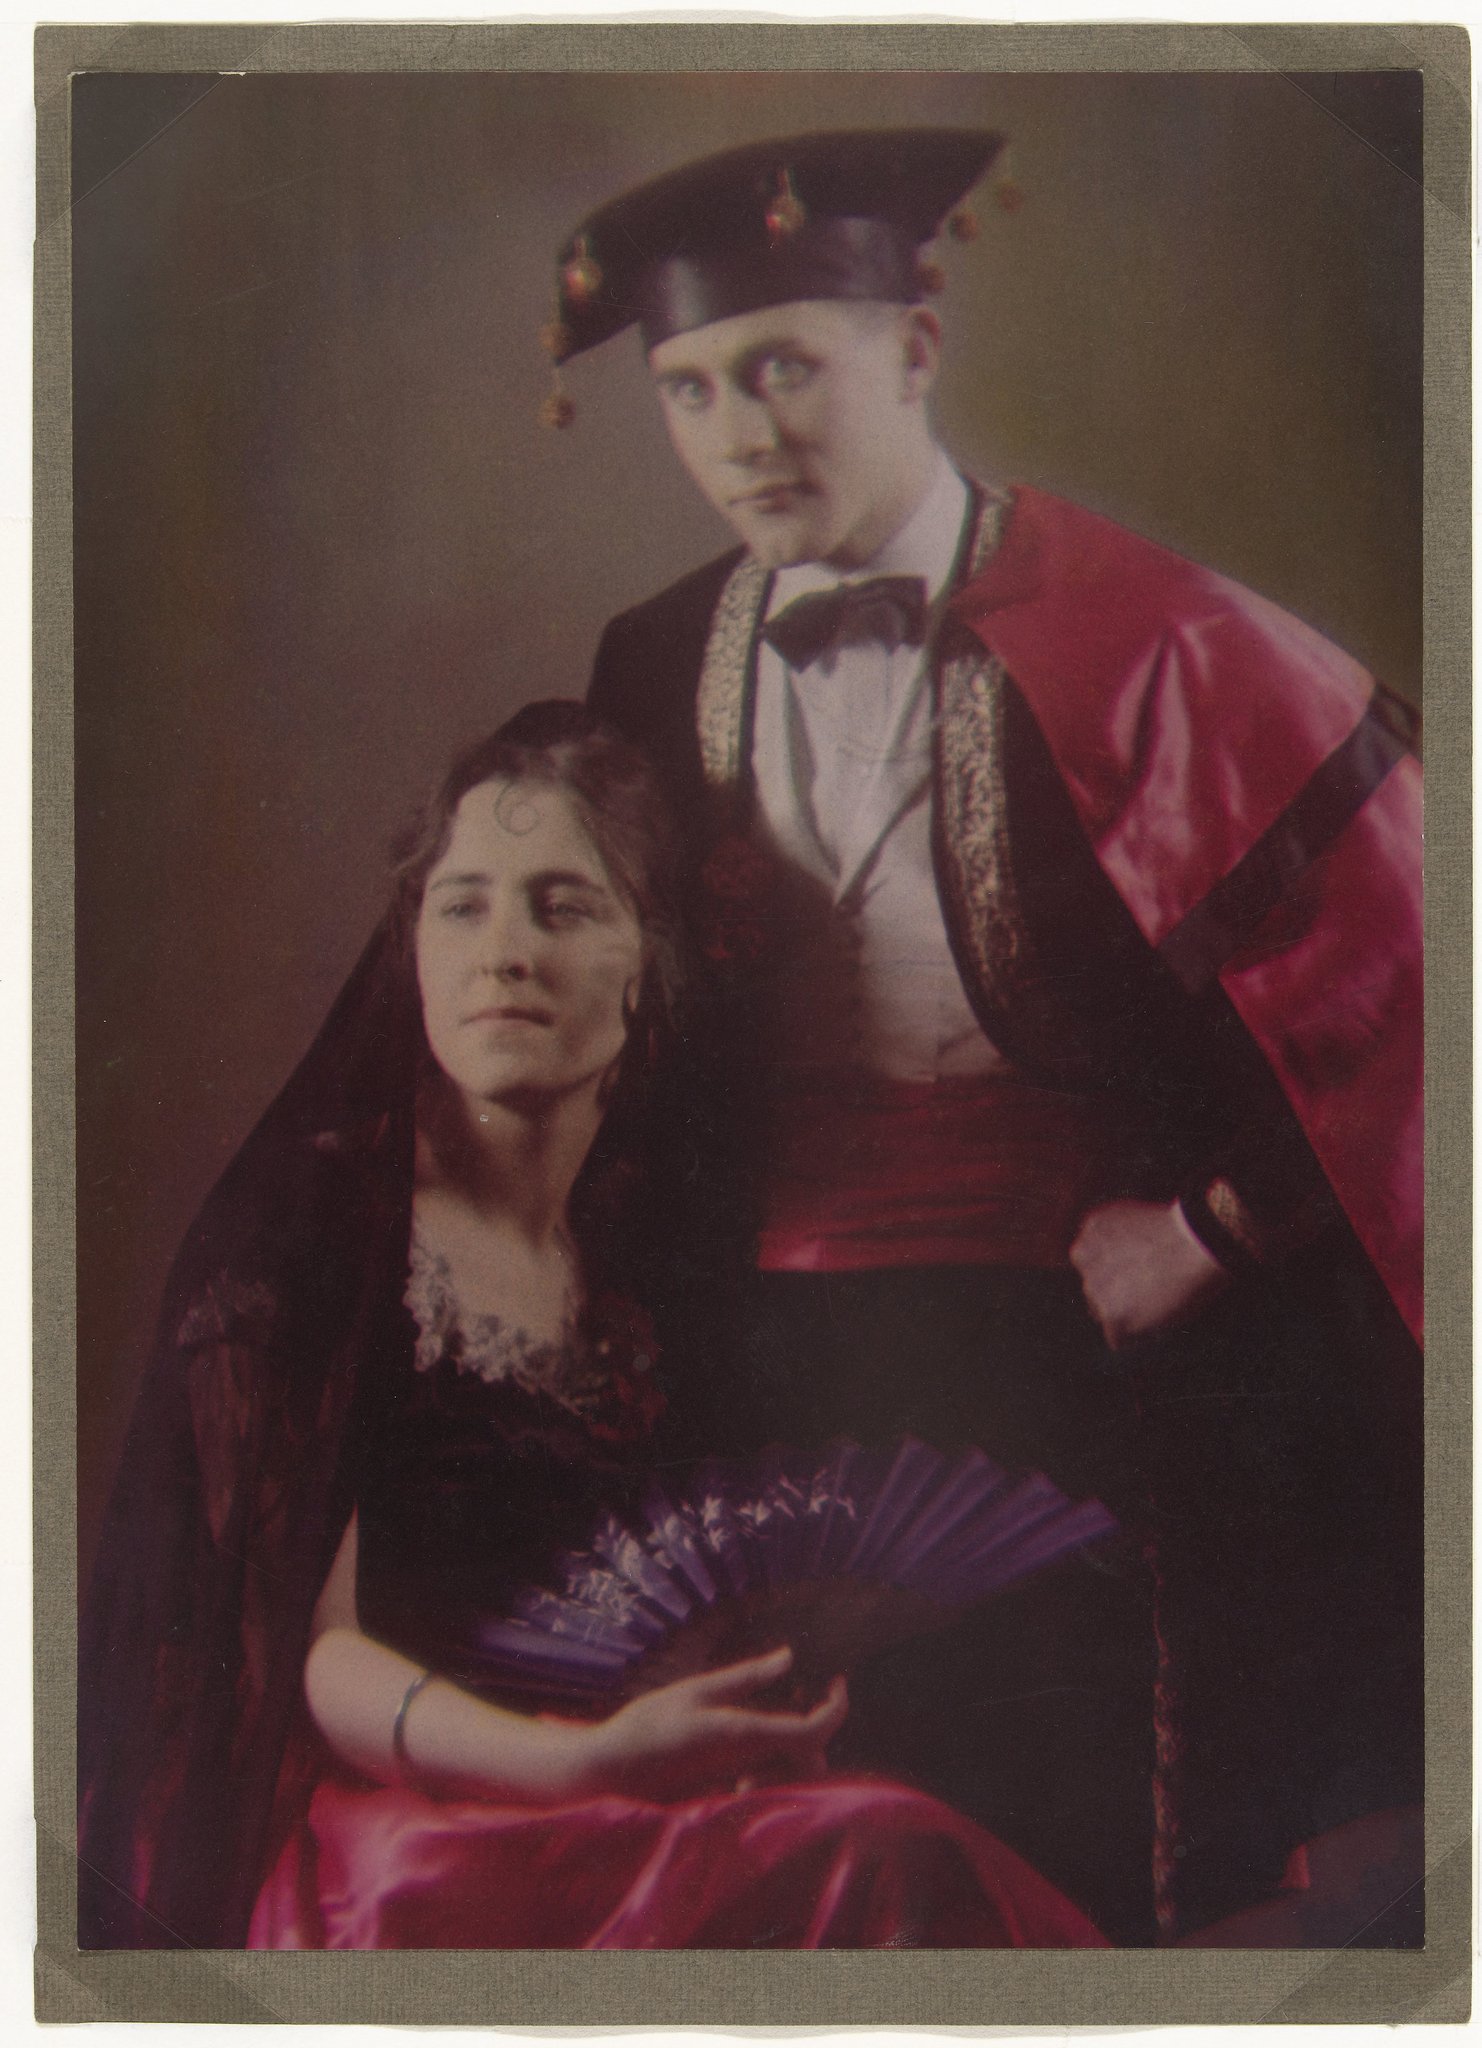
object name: photograph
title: Portret van Mies Rosenboom-Merkelbach en echtgenoot in Spaans kostuum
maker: jacob merkelbach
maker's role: fotograaf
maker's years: 1877-1942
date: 1920-1930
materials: photographic support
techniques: jos-pé print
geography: amsterdam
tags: historical persons (portraits and scenes from the life) - bb - woman, marriage, married couple, 'matrimonium'